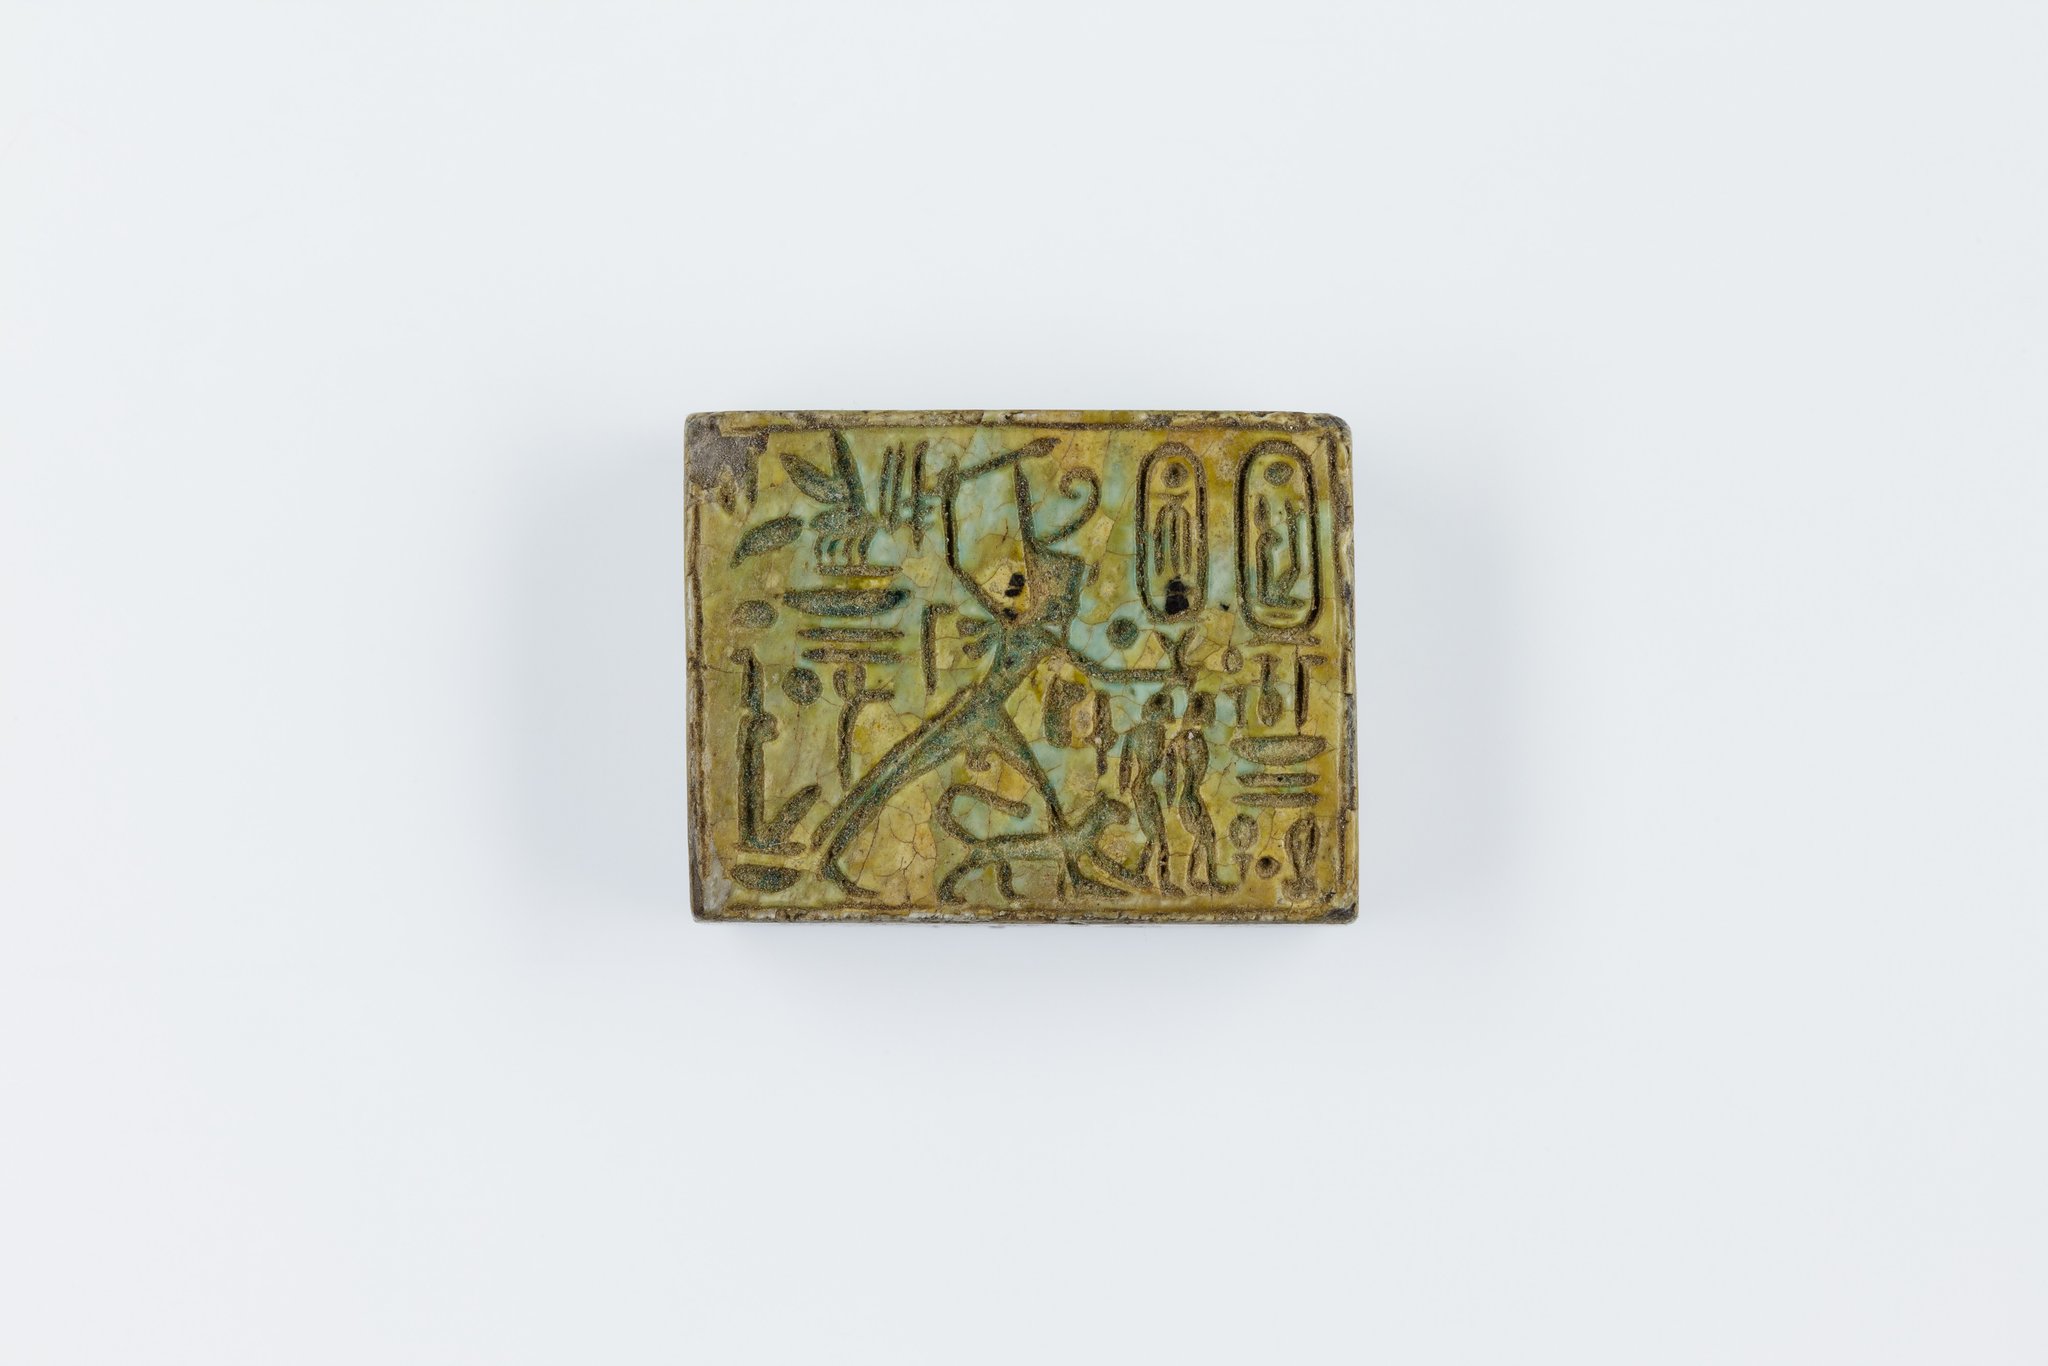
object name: plaque, ramesses ii smiting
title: Oblong Plaque Depicting Ramesses II Smiting Enemies, opposite side relief scene of Isis and Nephthys flanking falcon labeled Horus son of Isis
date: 1279-1213 BCE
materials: stone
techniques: glazing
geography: egypt